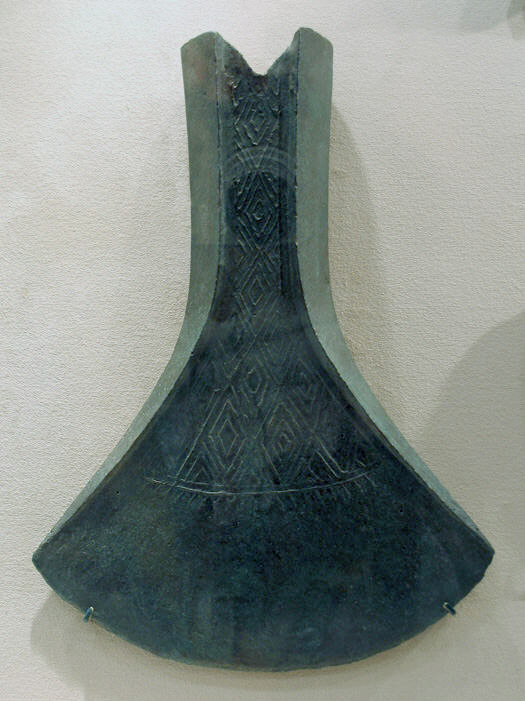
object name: ax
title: Swallowtail Hafted Ax with Diamond Pattern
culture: indonesian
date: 500 BCE-300 CE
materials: bronze